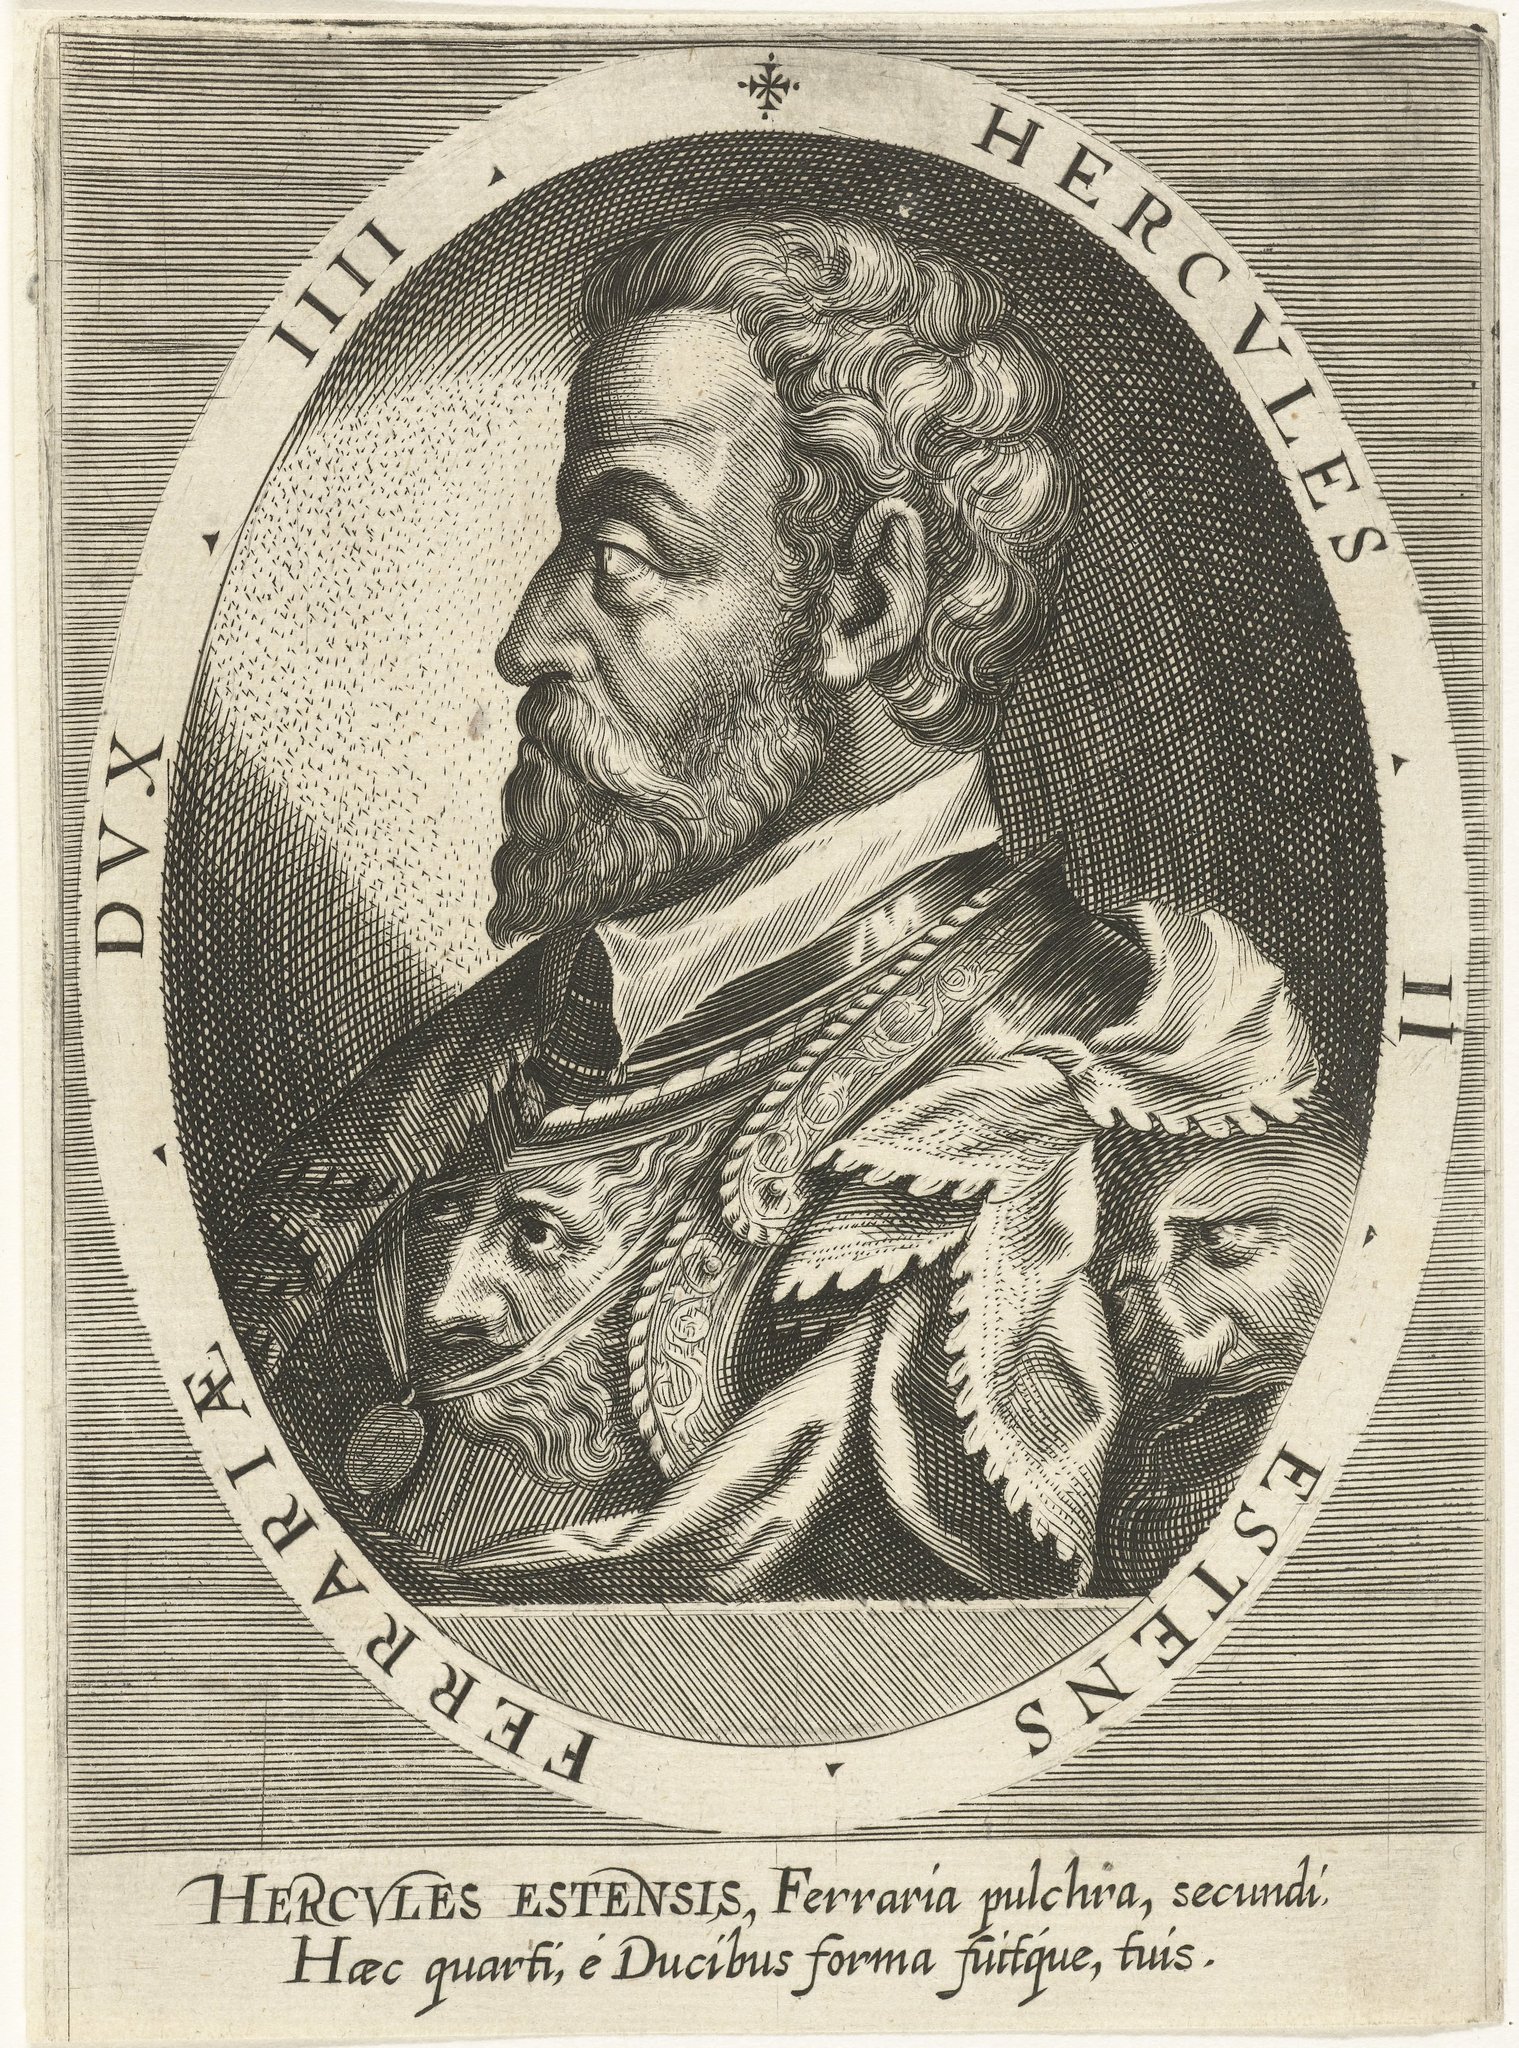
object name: print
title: Portret van Ercole II d'Este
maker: dominicus custos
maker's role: print maker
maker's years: 1560-1615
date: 1600-1604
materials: paper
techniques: engraving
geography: augsburg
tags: ferrara (stad), hertog, ercole ii d'este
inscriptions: collector's mark: Lugt 2228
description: Illustratie uit: D. Custos en M. Henning. Atrium heroicum Caesarum, regum aliorq. summatum ac procerum qui intra proximum seculum vixere, aut hodie supersunt, imaginib. Deel 1-4. Augsburg: D. Custos, 1600-1604.